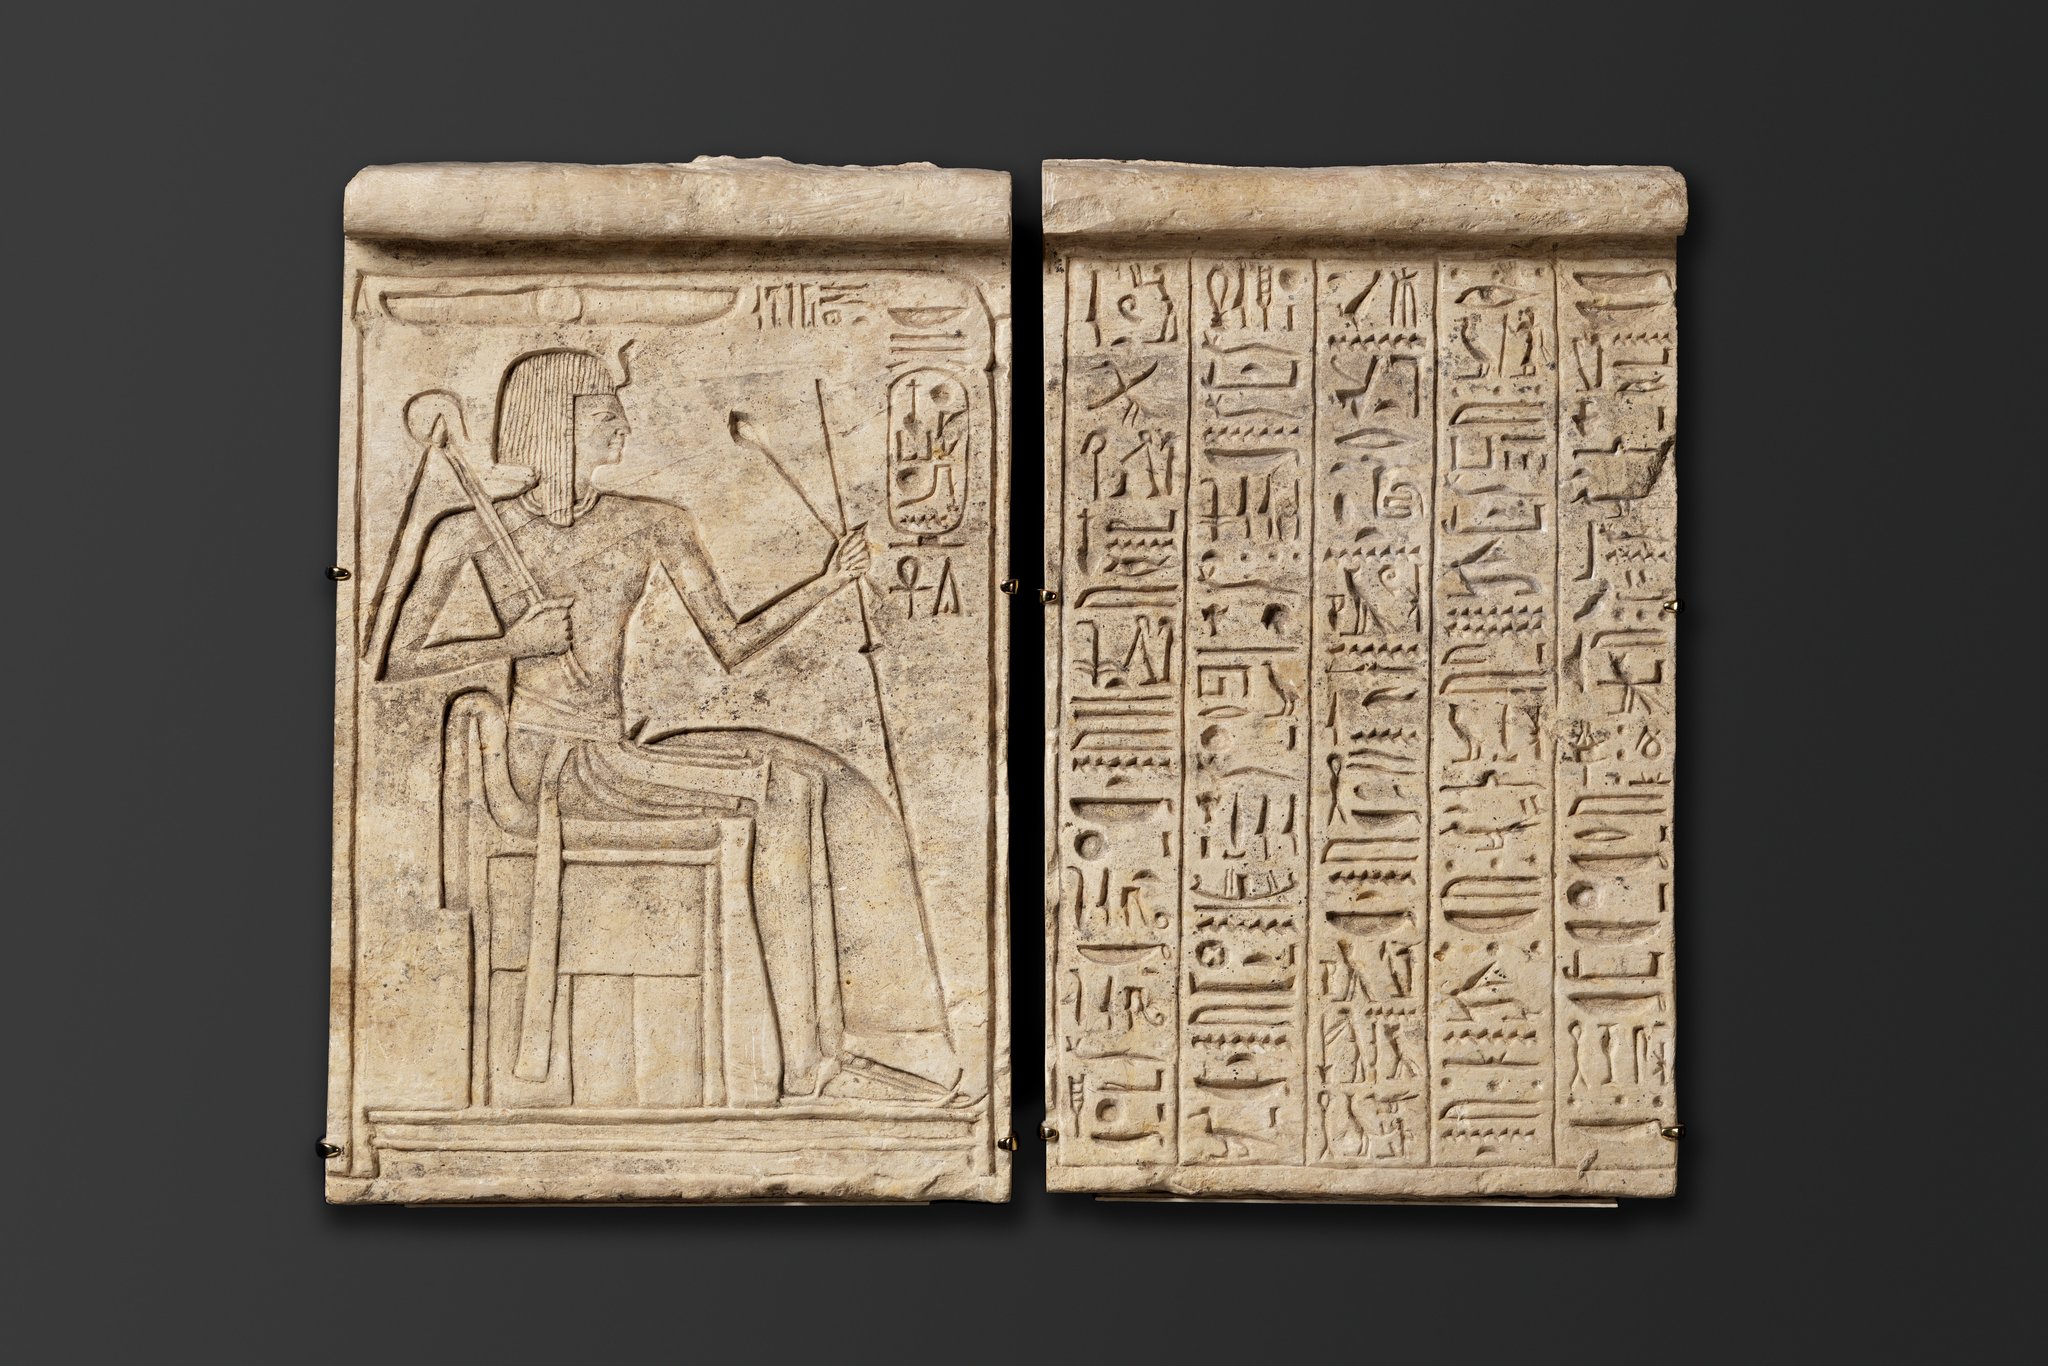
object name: relief, ramesses ix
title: Relief of Ramesses IX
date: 1126-1108 BCE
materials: limestone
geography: egypt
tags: kings,hieroglyphs